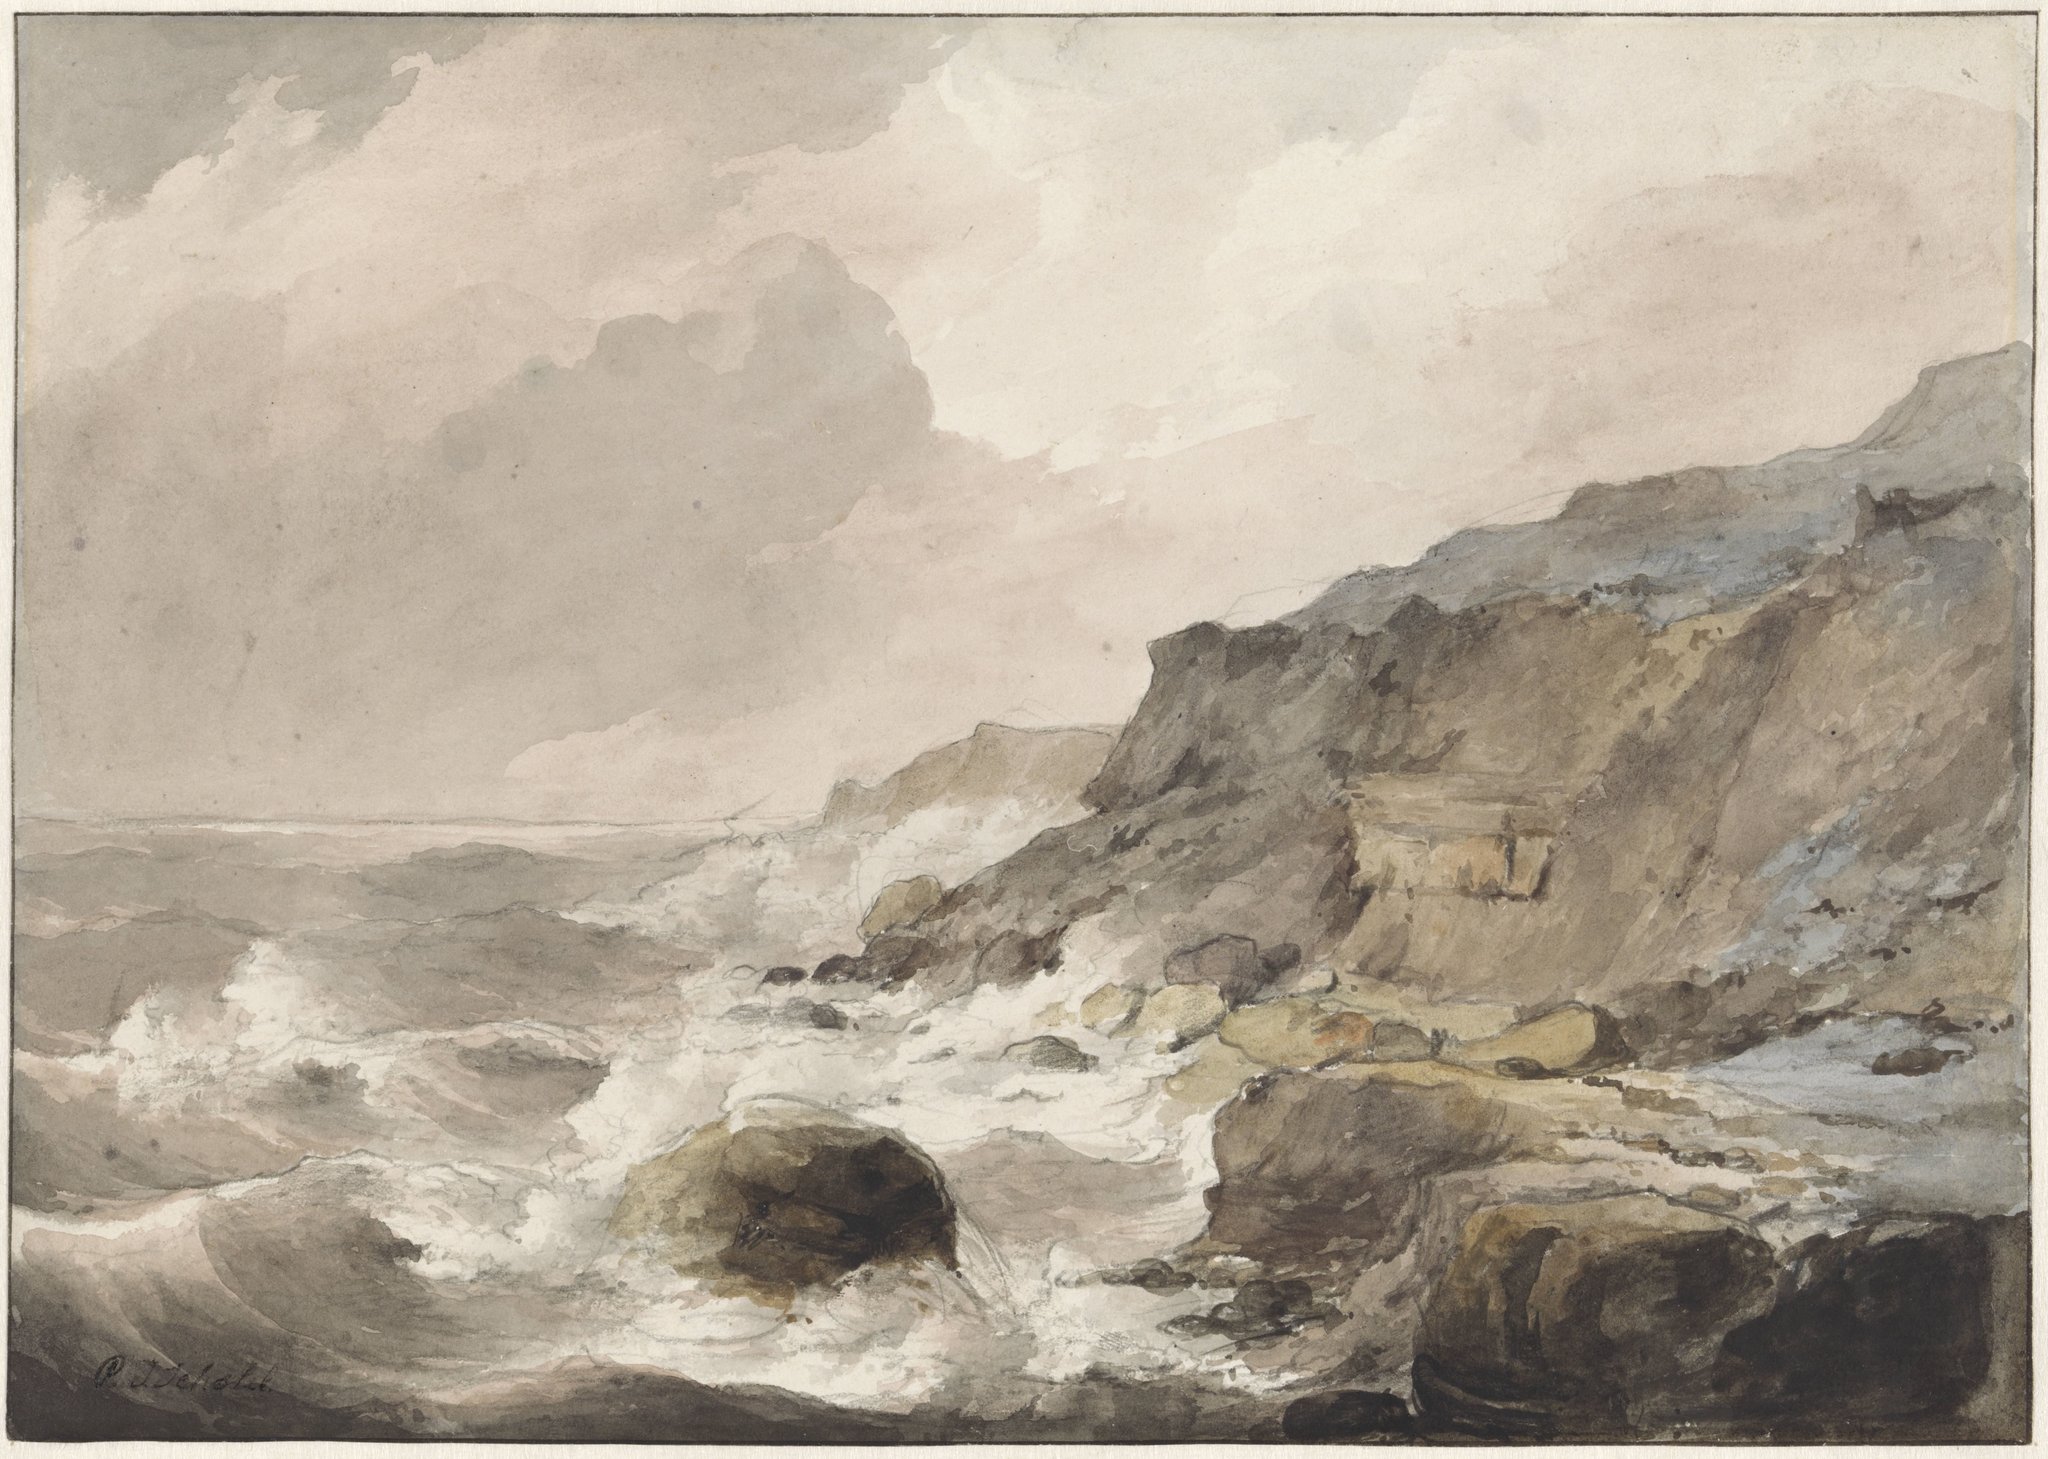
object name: drawing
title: Rotskust te Boulogne sur Mer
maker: petrus johannes schotel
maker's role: draughtsman, painter, print maker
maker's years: 1808-1865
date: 1829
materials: paper, pencil, watercolor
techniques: brush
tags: rocky coast